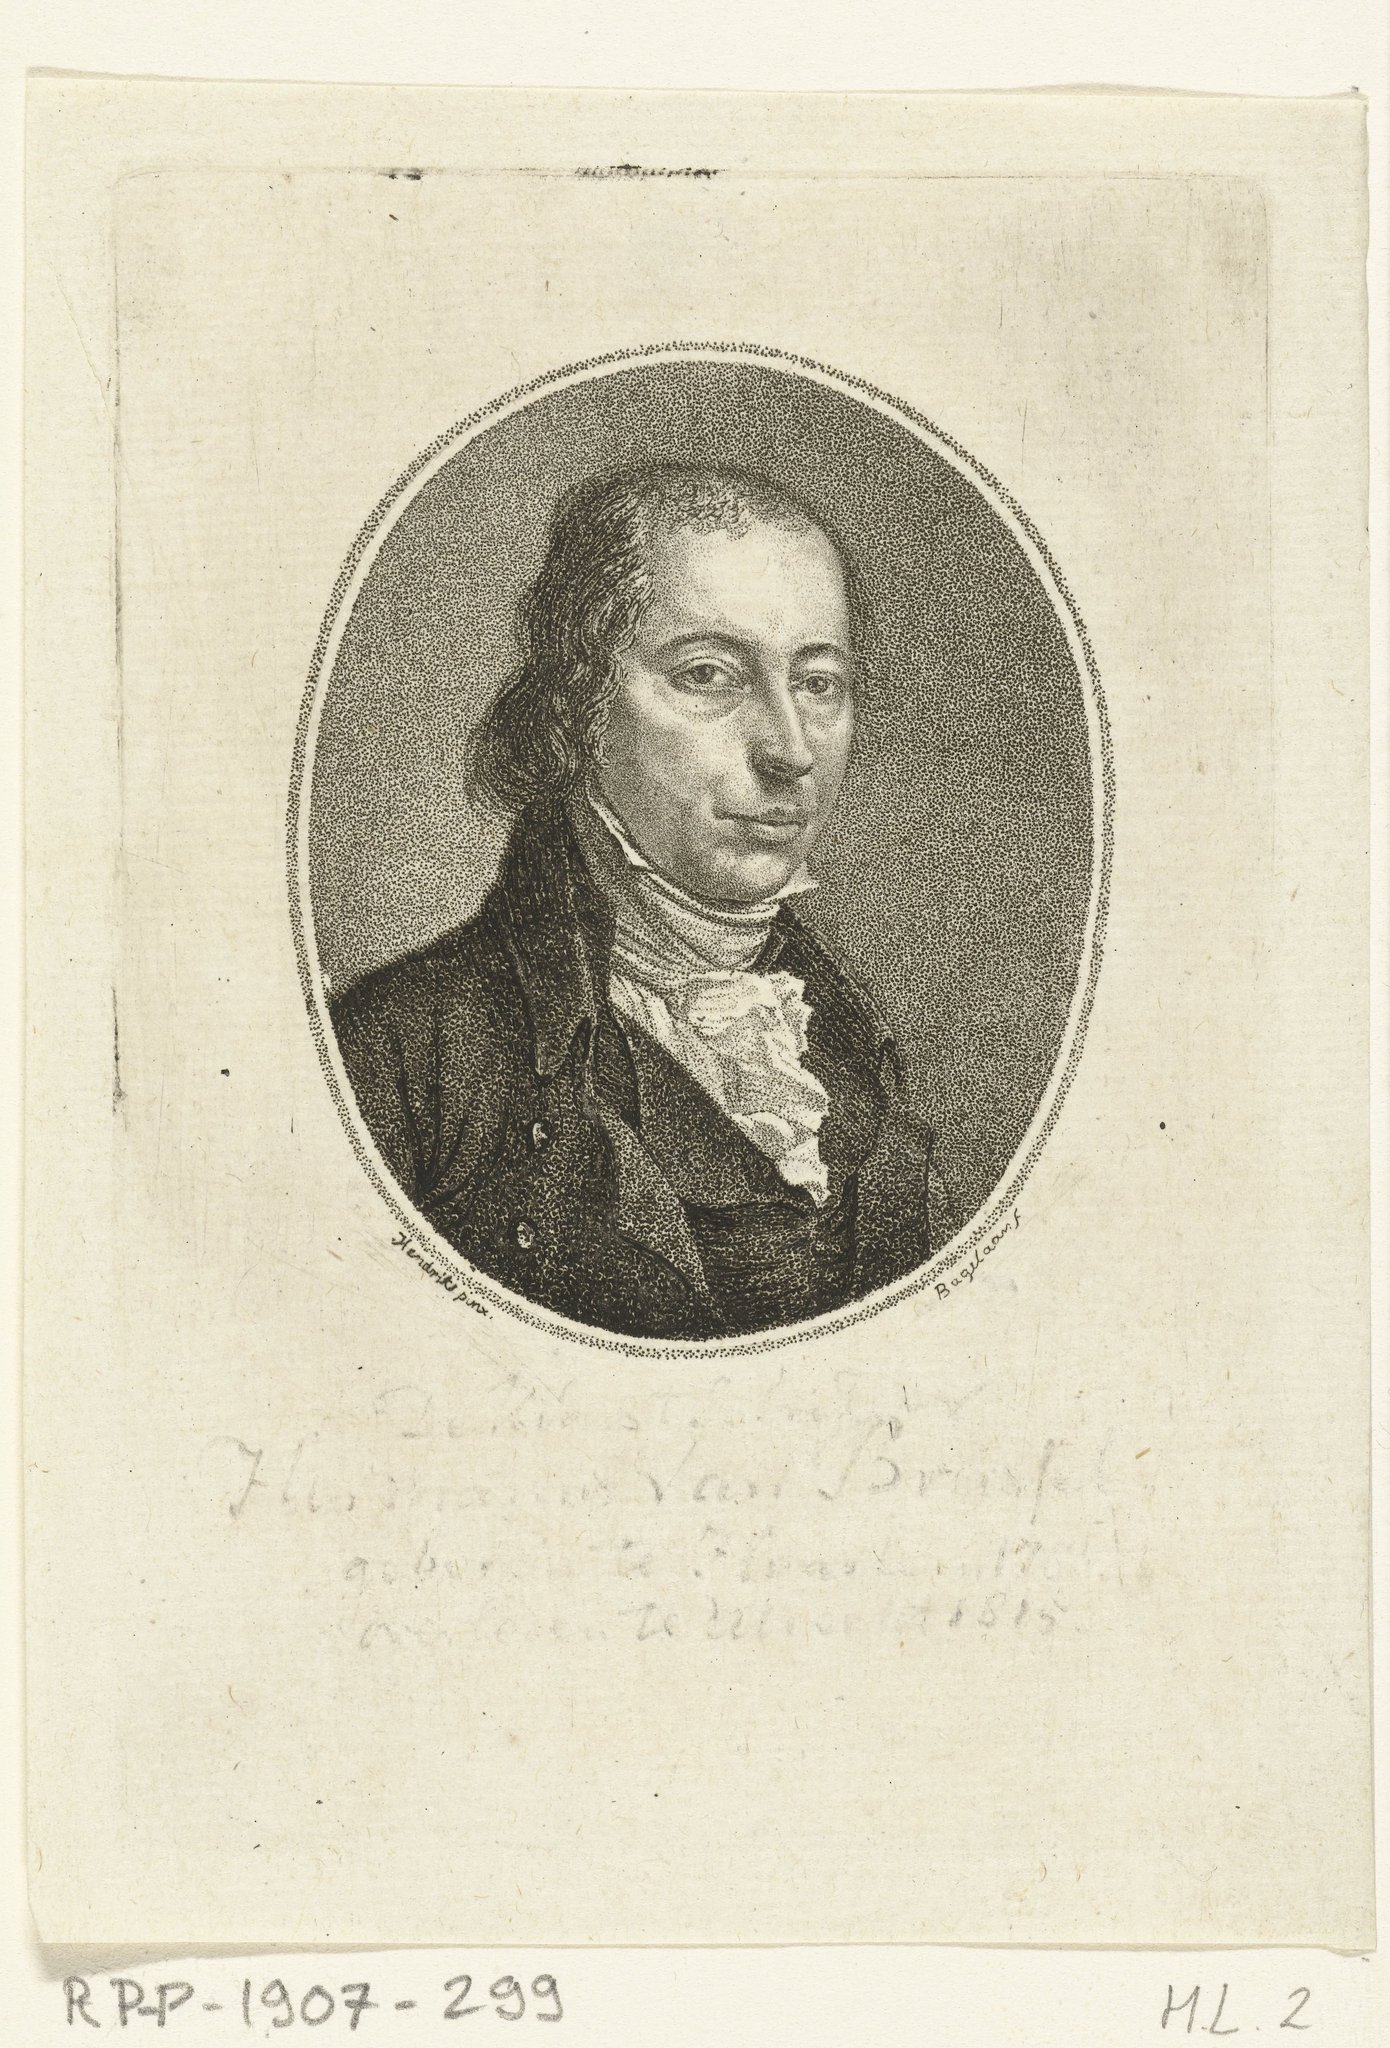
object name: print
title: Portret van Hermanus van Brussel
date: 1798-1815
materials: paper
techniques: etching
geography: netherlands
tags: haarlem, utrecht, print maker, draughtsman, hermanus van brussel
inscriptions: collector's mark: Lugt 2228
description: Portretbuste van Hermanus van Brussel, in ovaal naar rechts.